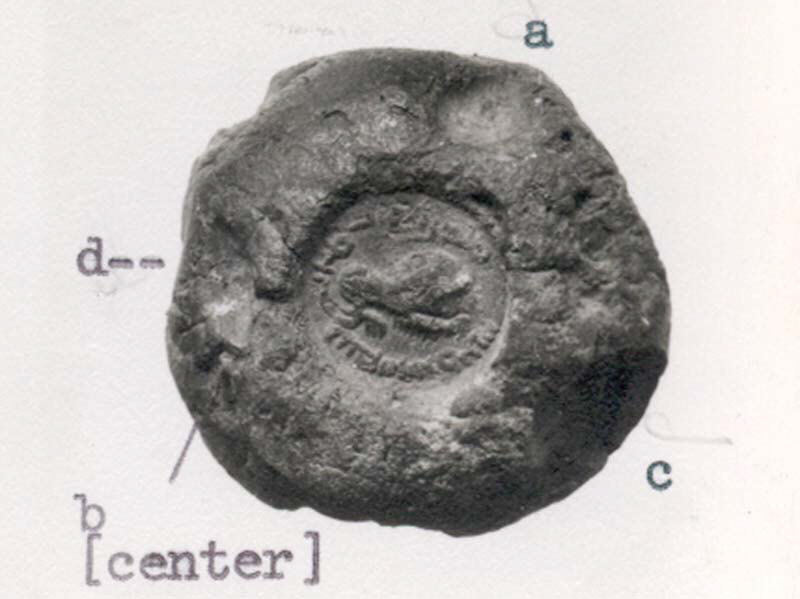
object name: sealing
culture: sasanian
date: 601-700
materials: clay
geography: iran